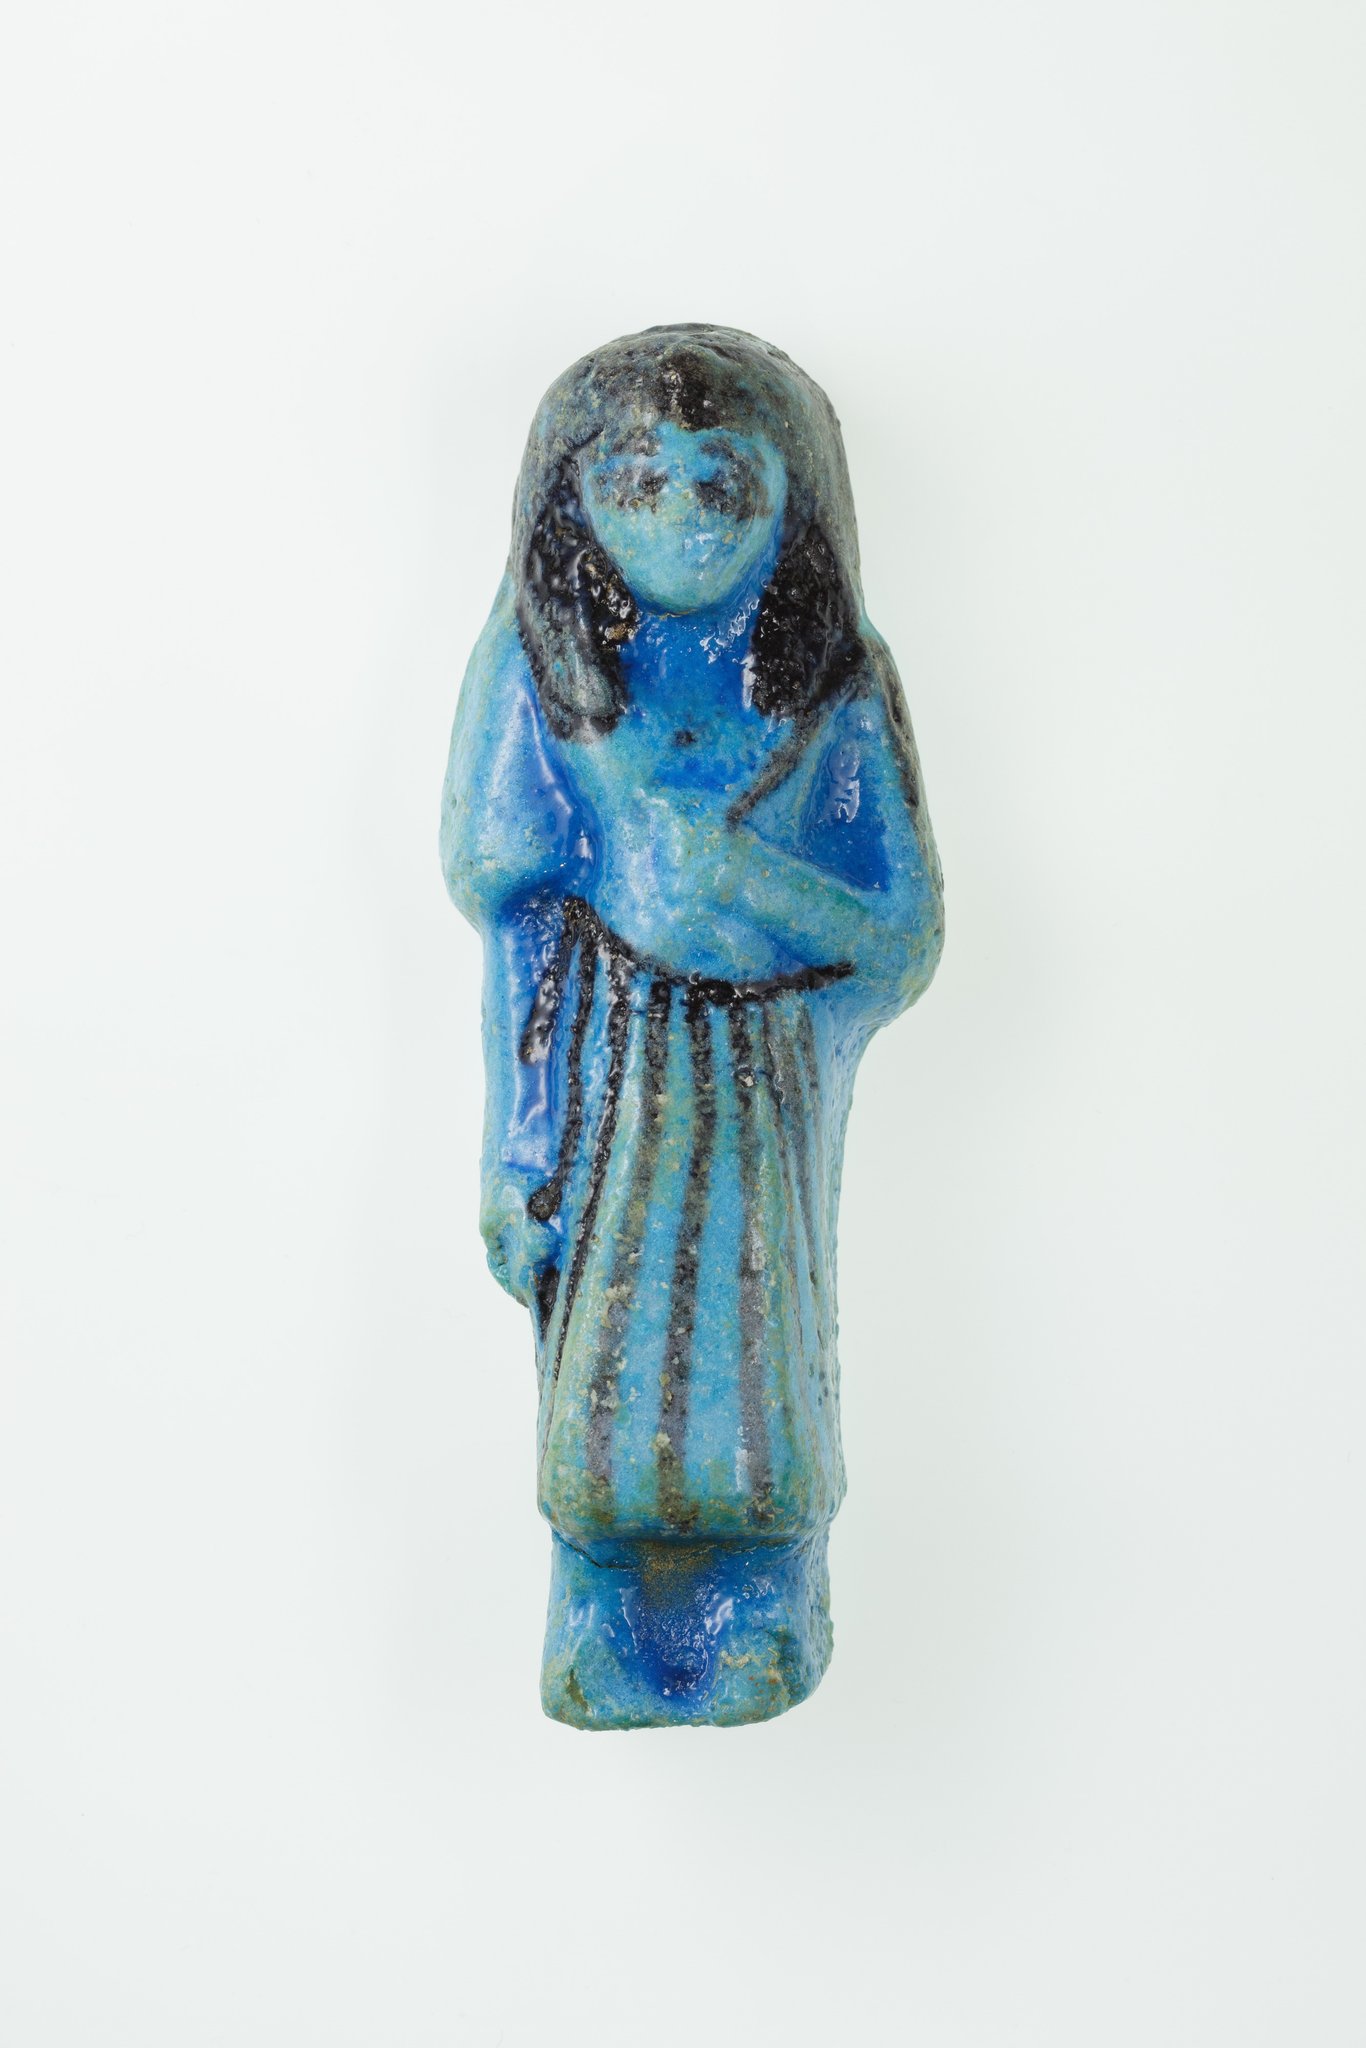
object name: shabti, overseer, nauny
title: Overseer Shabti of Nauny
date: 1050 BCE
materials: faience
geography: egypt